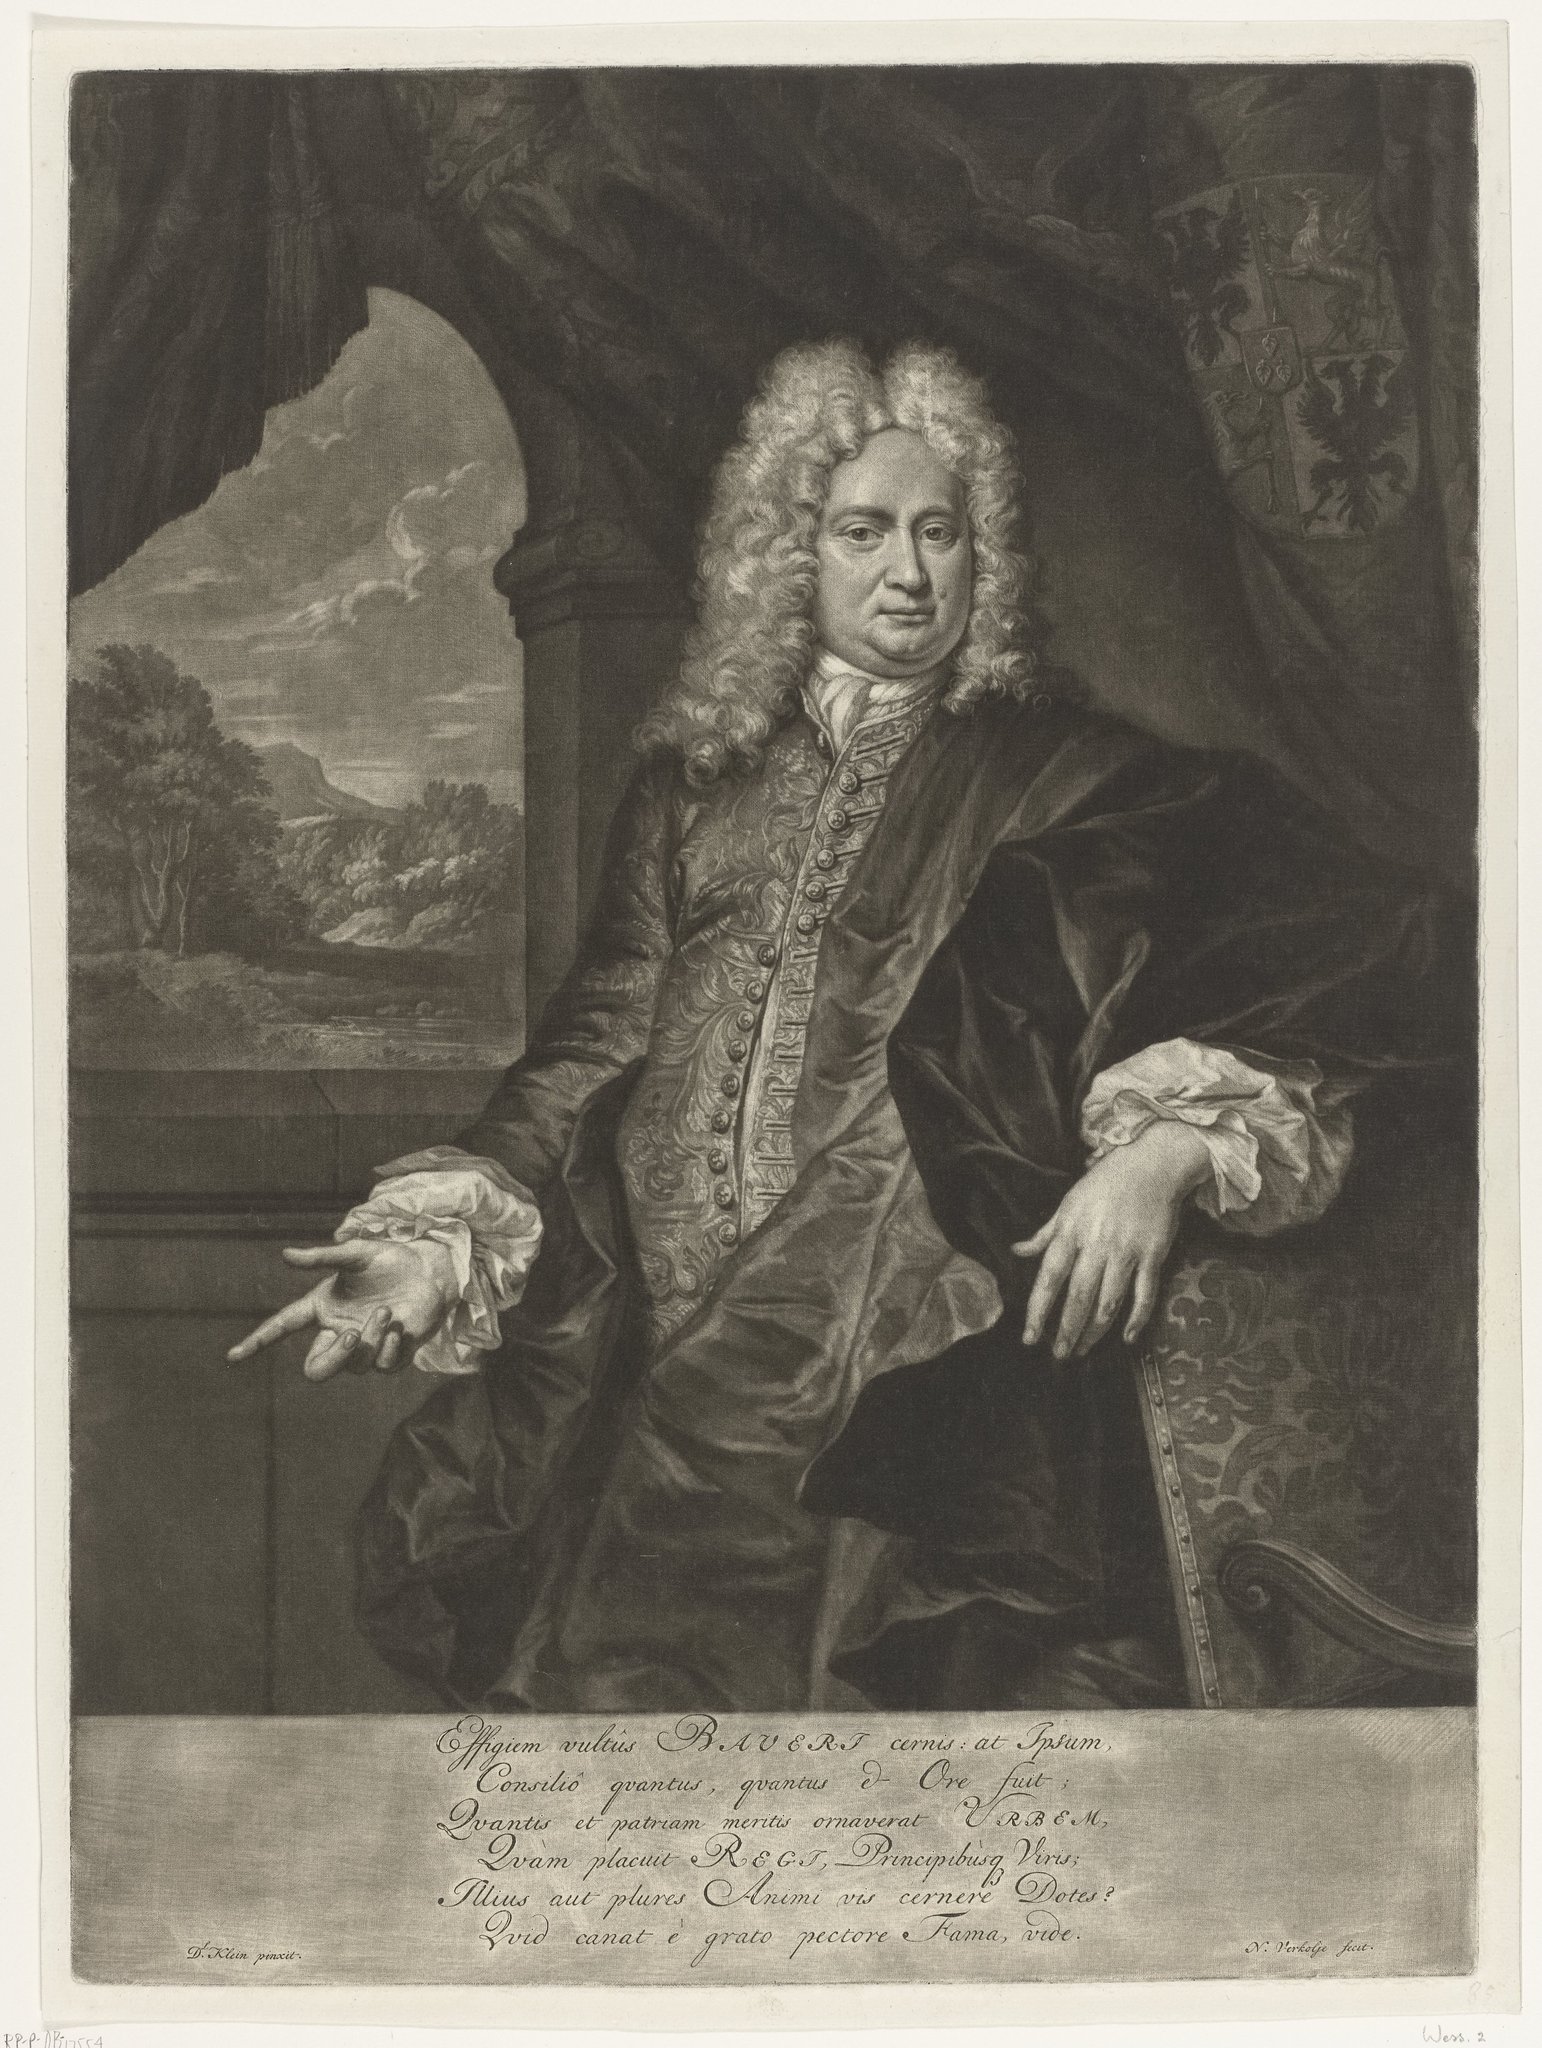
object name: print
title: Portret van een man, mogelijk de jurist Johann Gottfried Bauer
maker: daniel klein (i)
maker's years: 1672-1744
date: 1683-1746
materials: paper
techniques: mezzotint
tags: landscapes, wig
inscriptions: collector's mark: Lugt 240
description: De identiteit van de geportretteerde is niet zeker. Drugulin schrijft: 'N Bauer, Burgermeister in Danzig' (Drug 1071). In Singer (5396) staat hij als 'Edward Bauer, Jurist (in Leipzig) c.1740'.